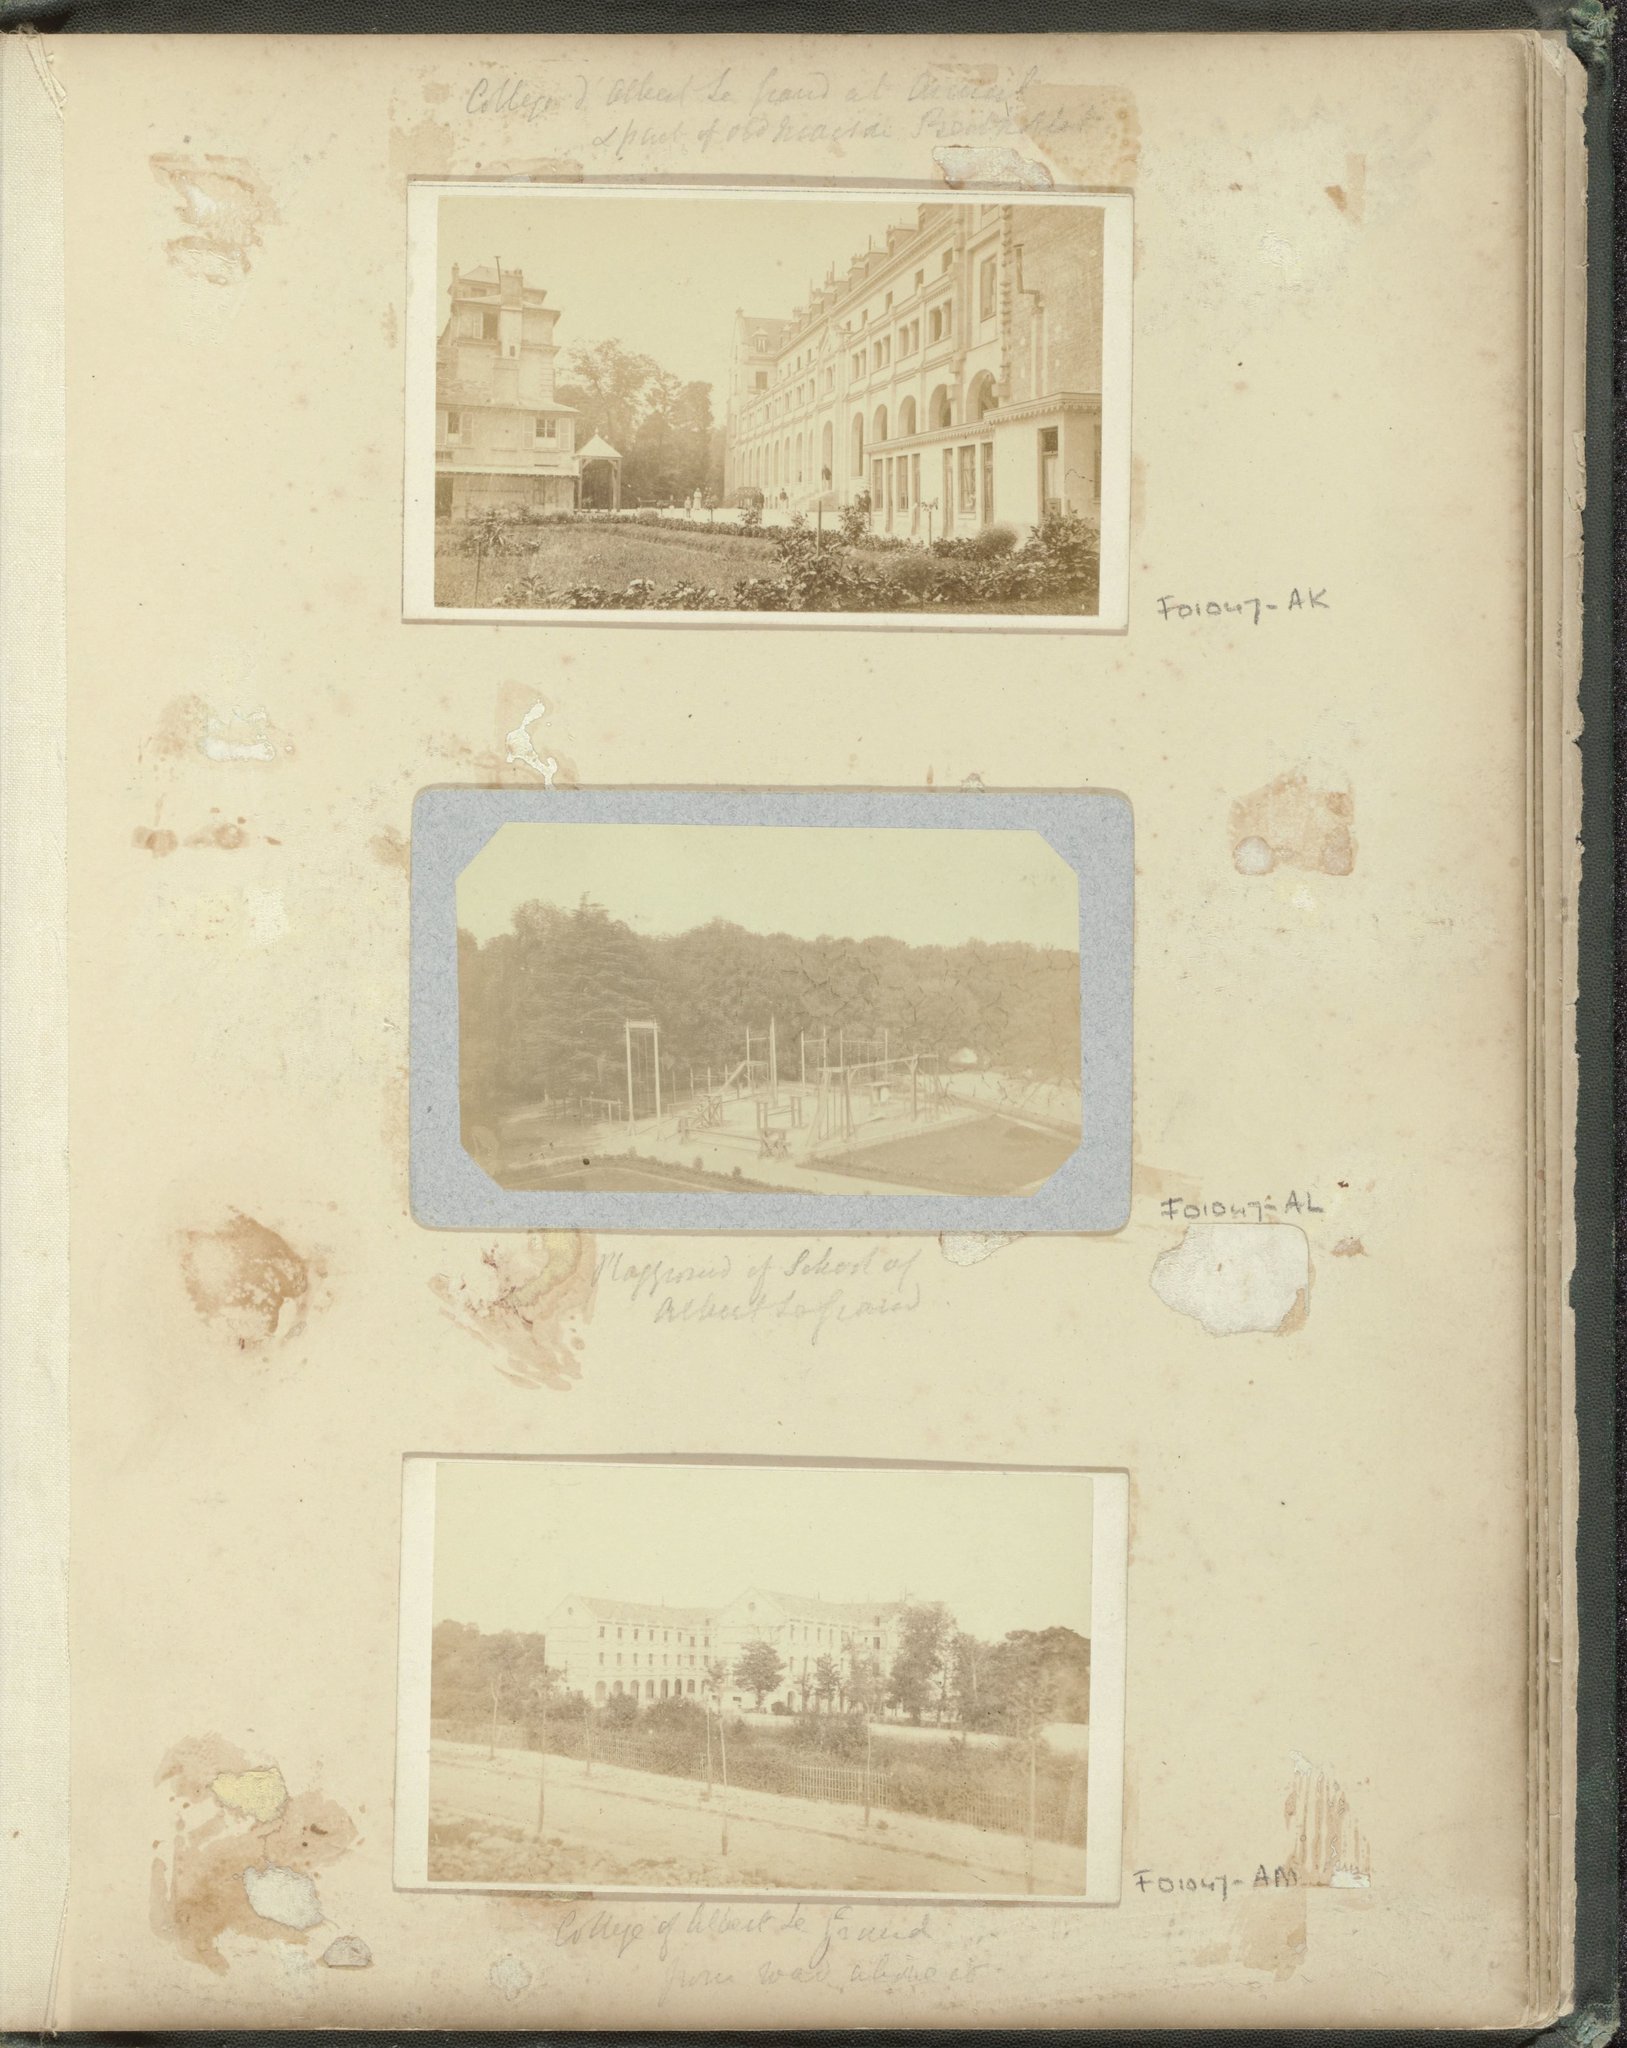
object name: photograph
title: Gezicht op het Collège d'Albert-le-Grand in Arcueil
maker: Anonymous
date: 1871-1900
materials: cardboard, paper, photographic support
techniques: albumen print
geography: arcueil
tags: university building, college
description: Onderdeel van Herdenkingsalbum van rooms-katholieke geestelijken gevallen tijdens de Commune van Parijs.